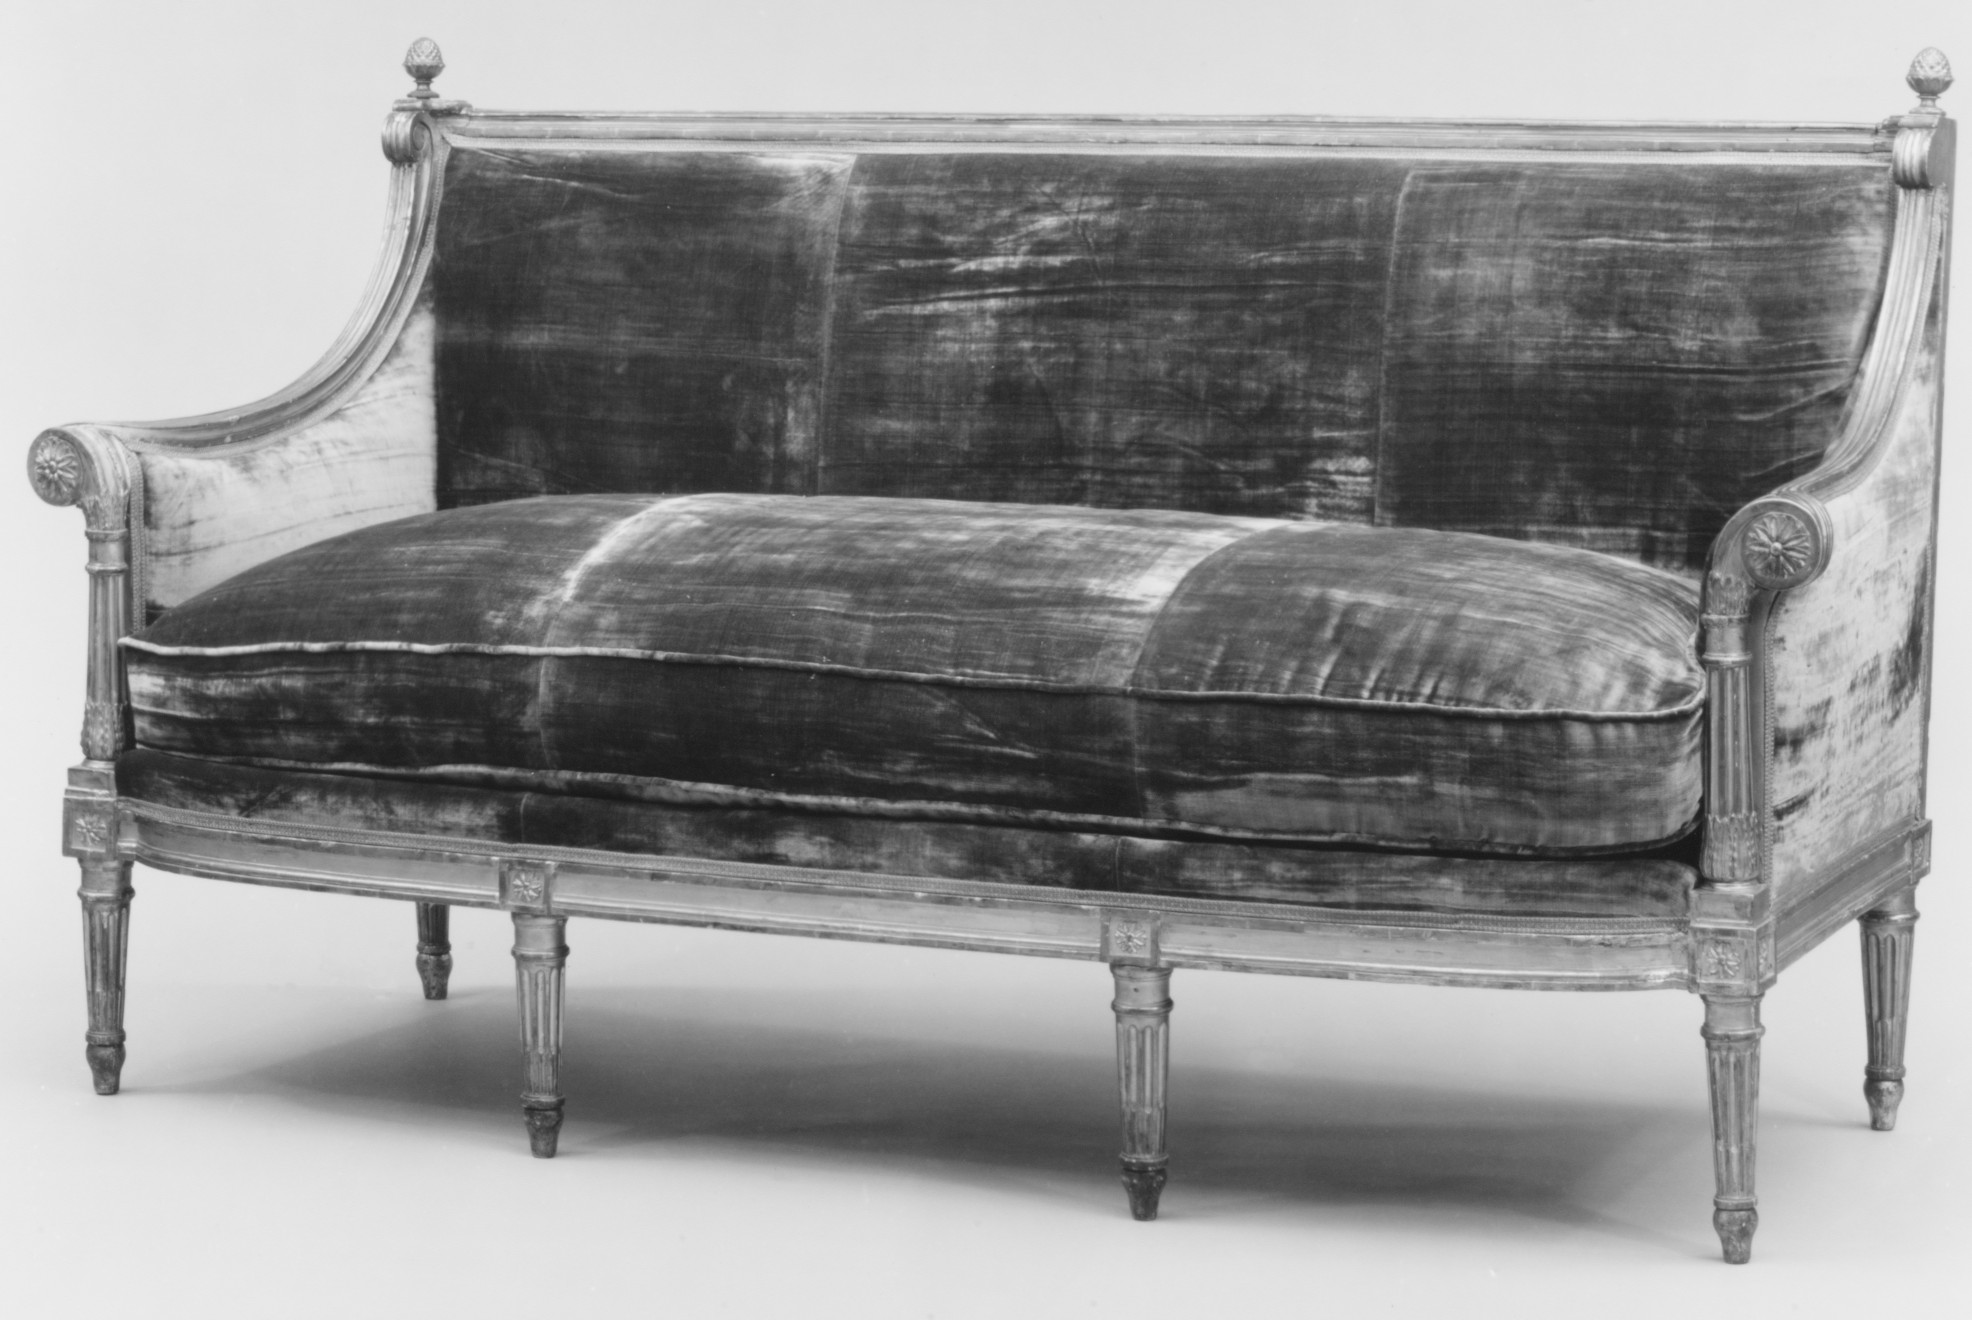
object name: sofa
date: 1785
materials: wood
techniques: carving, gilding